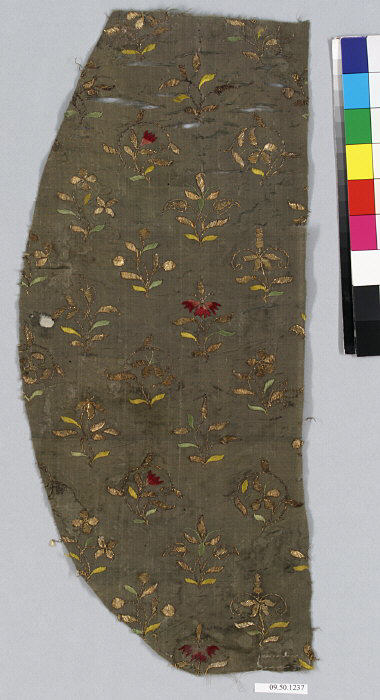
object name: fragment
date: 1701-1800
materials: metal thread, silk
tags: flowers,leaves